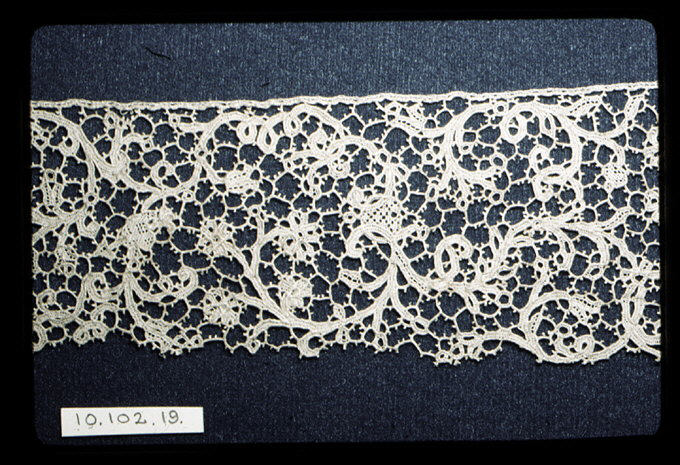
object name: fragment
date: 1601-1700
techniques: lace